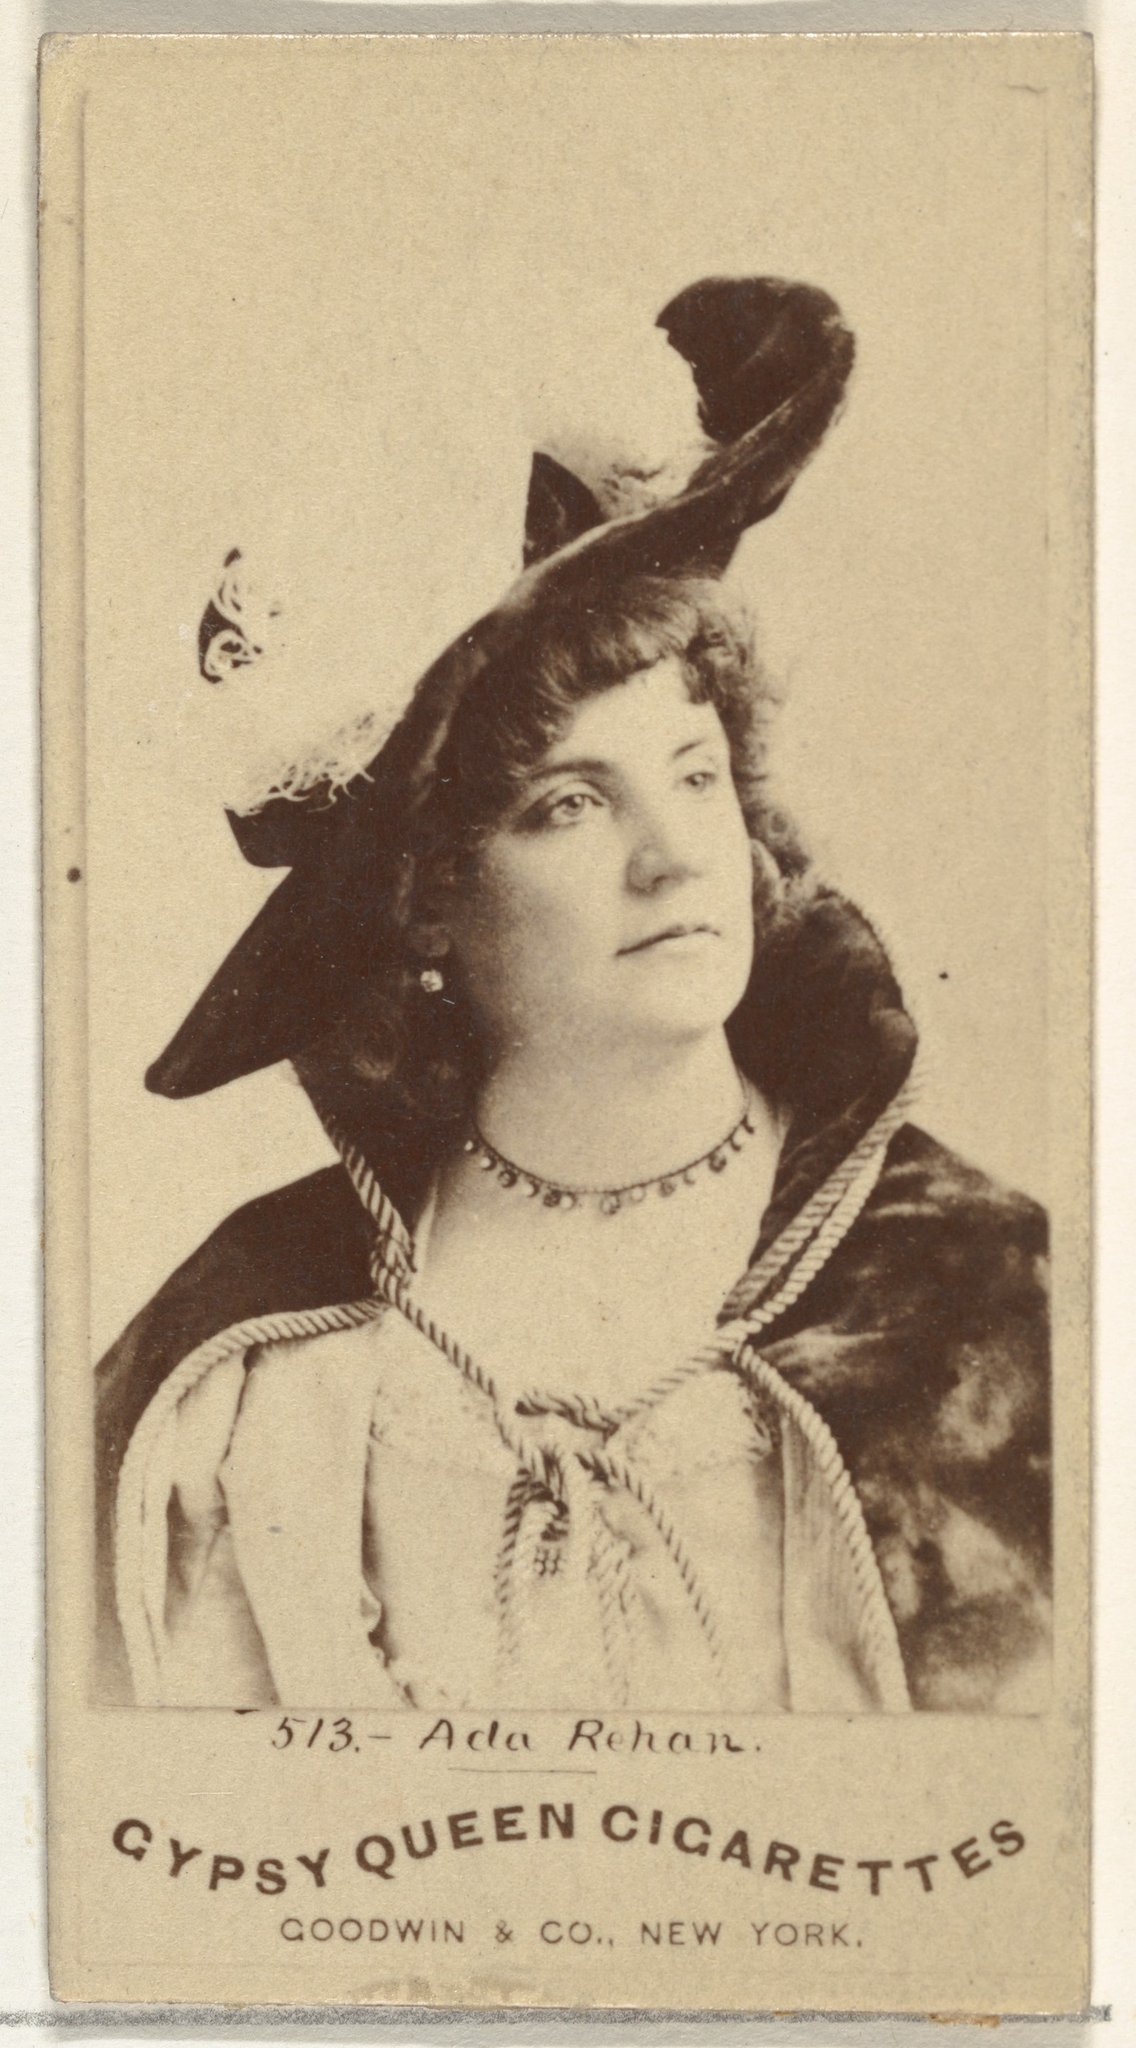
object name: photograph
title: Ada Rehan, from the Actors and Actresses series (N171) for Gypsy Queen Cigarettes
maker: goodwin & company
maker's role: publisher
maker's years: 1850-1950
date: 1886-1890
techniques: albumen silver print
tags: portraits,women,actresses